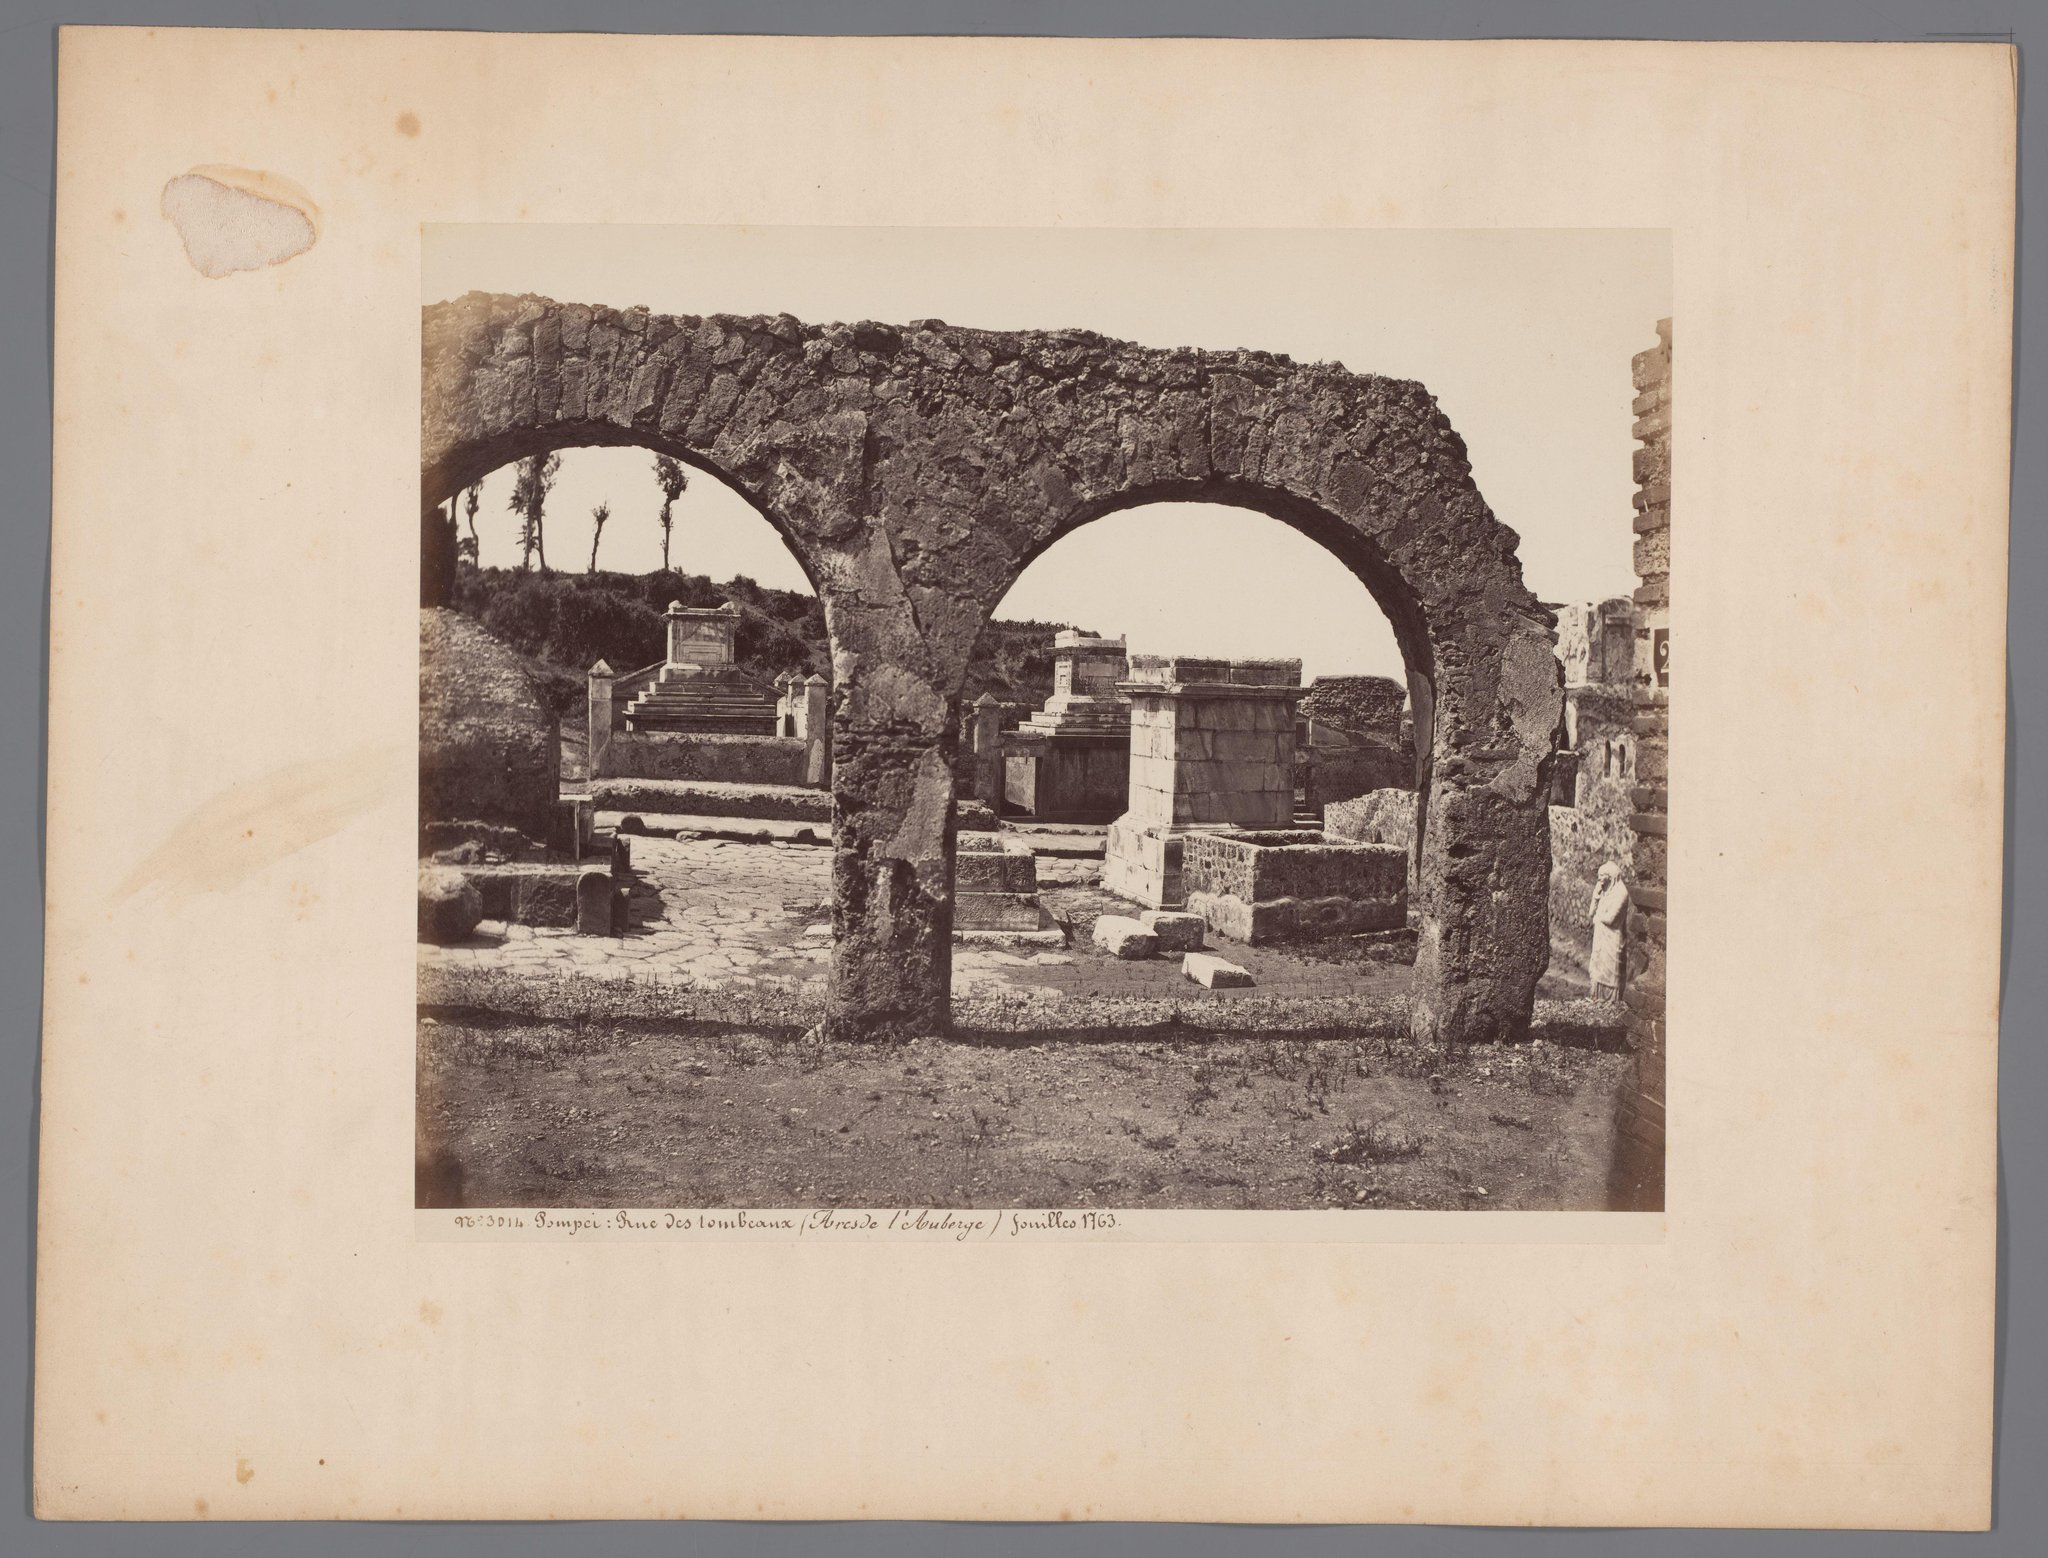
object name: photograph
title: Rue des tombeaux (Aresde l'Auberge) fouilles 1763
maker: giorgio sommer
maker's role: fotograaf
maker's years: 1834-1914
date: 1857-1914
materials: cardboard, paper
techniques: albumen print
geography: pompeii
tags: ruin of a building ~ architecture, pompeii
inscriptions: inscription: ‘Sommer (t)’, number: ‘17.’, number: ‘10’, number: ‘No. 3014.’